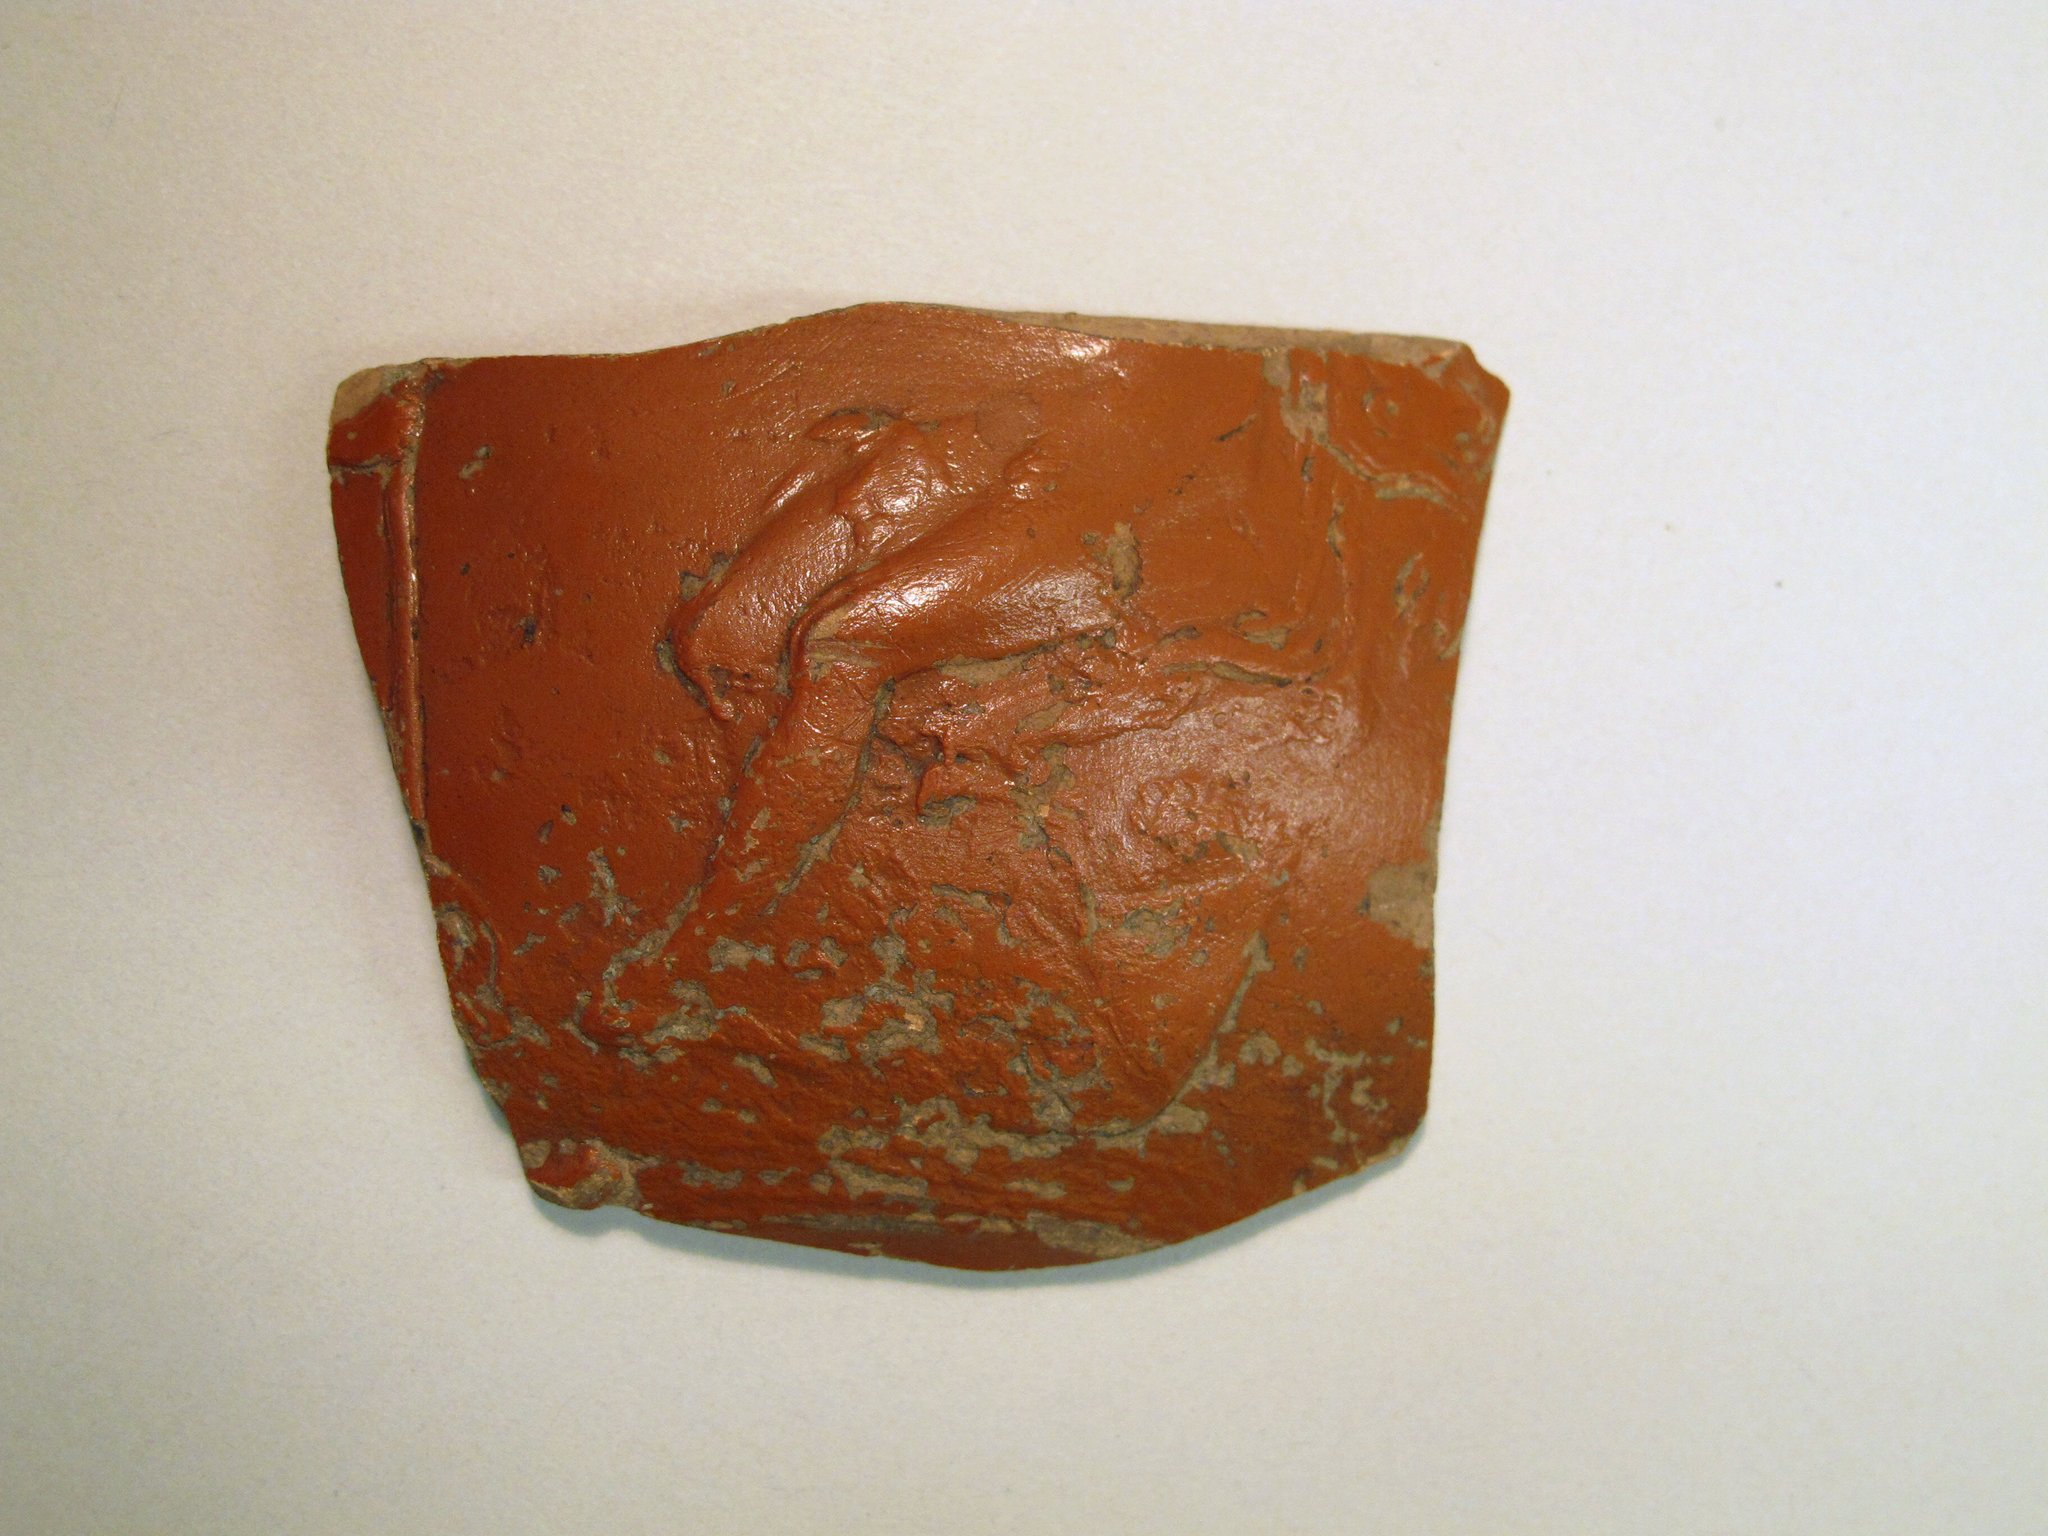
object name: vase fragment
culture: roman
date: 670 BCE-330 CE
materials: terracotta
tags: men